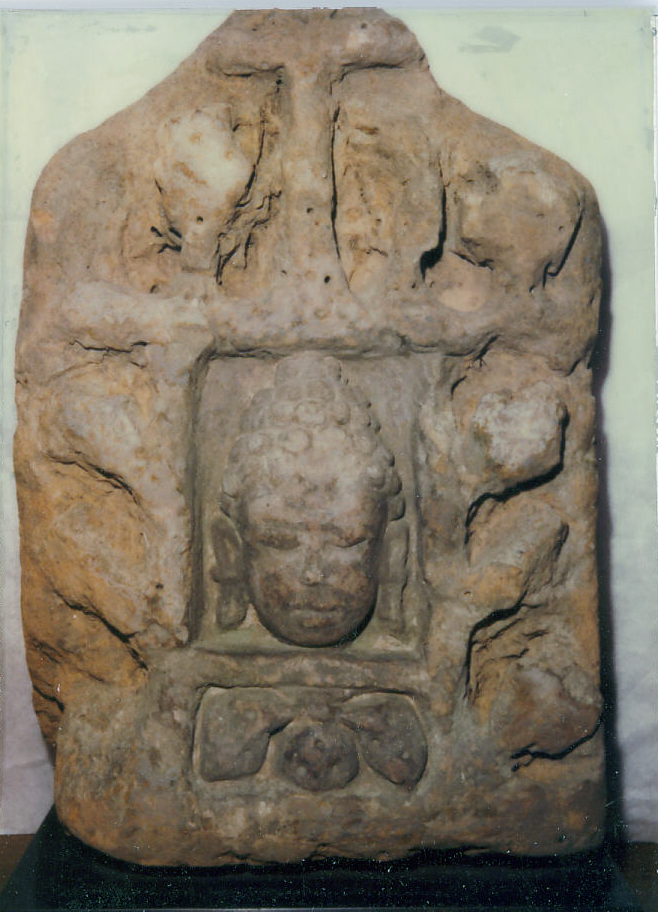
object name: antefix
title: Antefix with Head of a Buddha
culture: indonesian, javanese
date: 801-1000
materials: terracotta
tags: heads,buddha